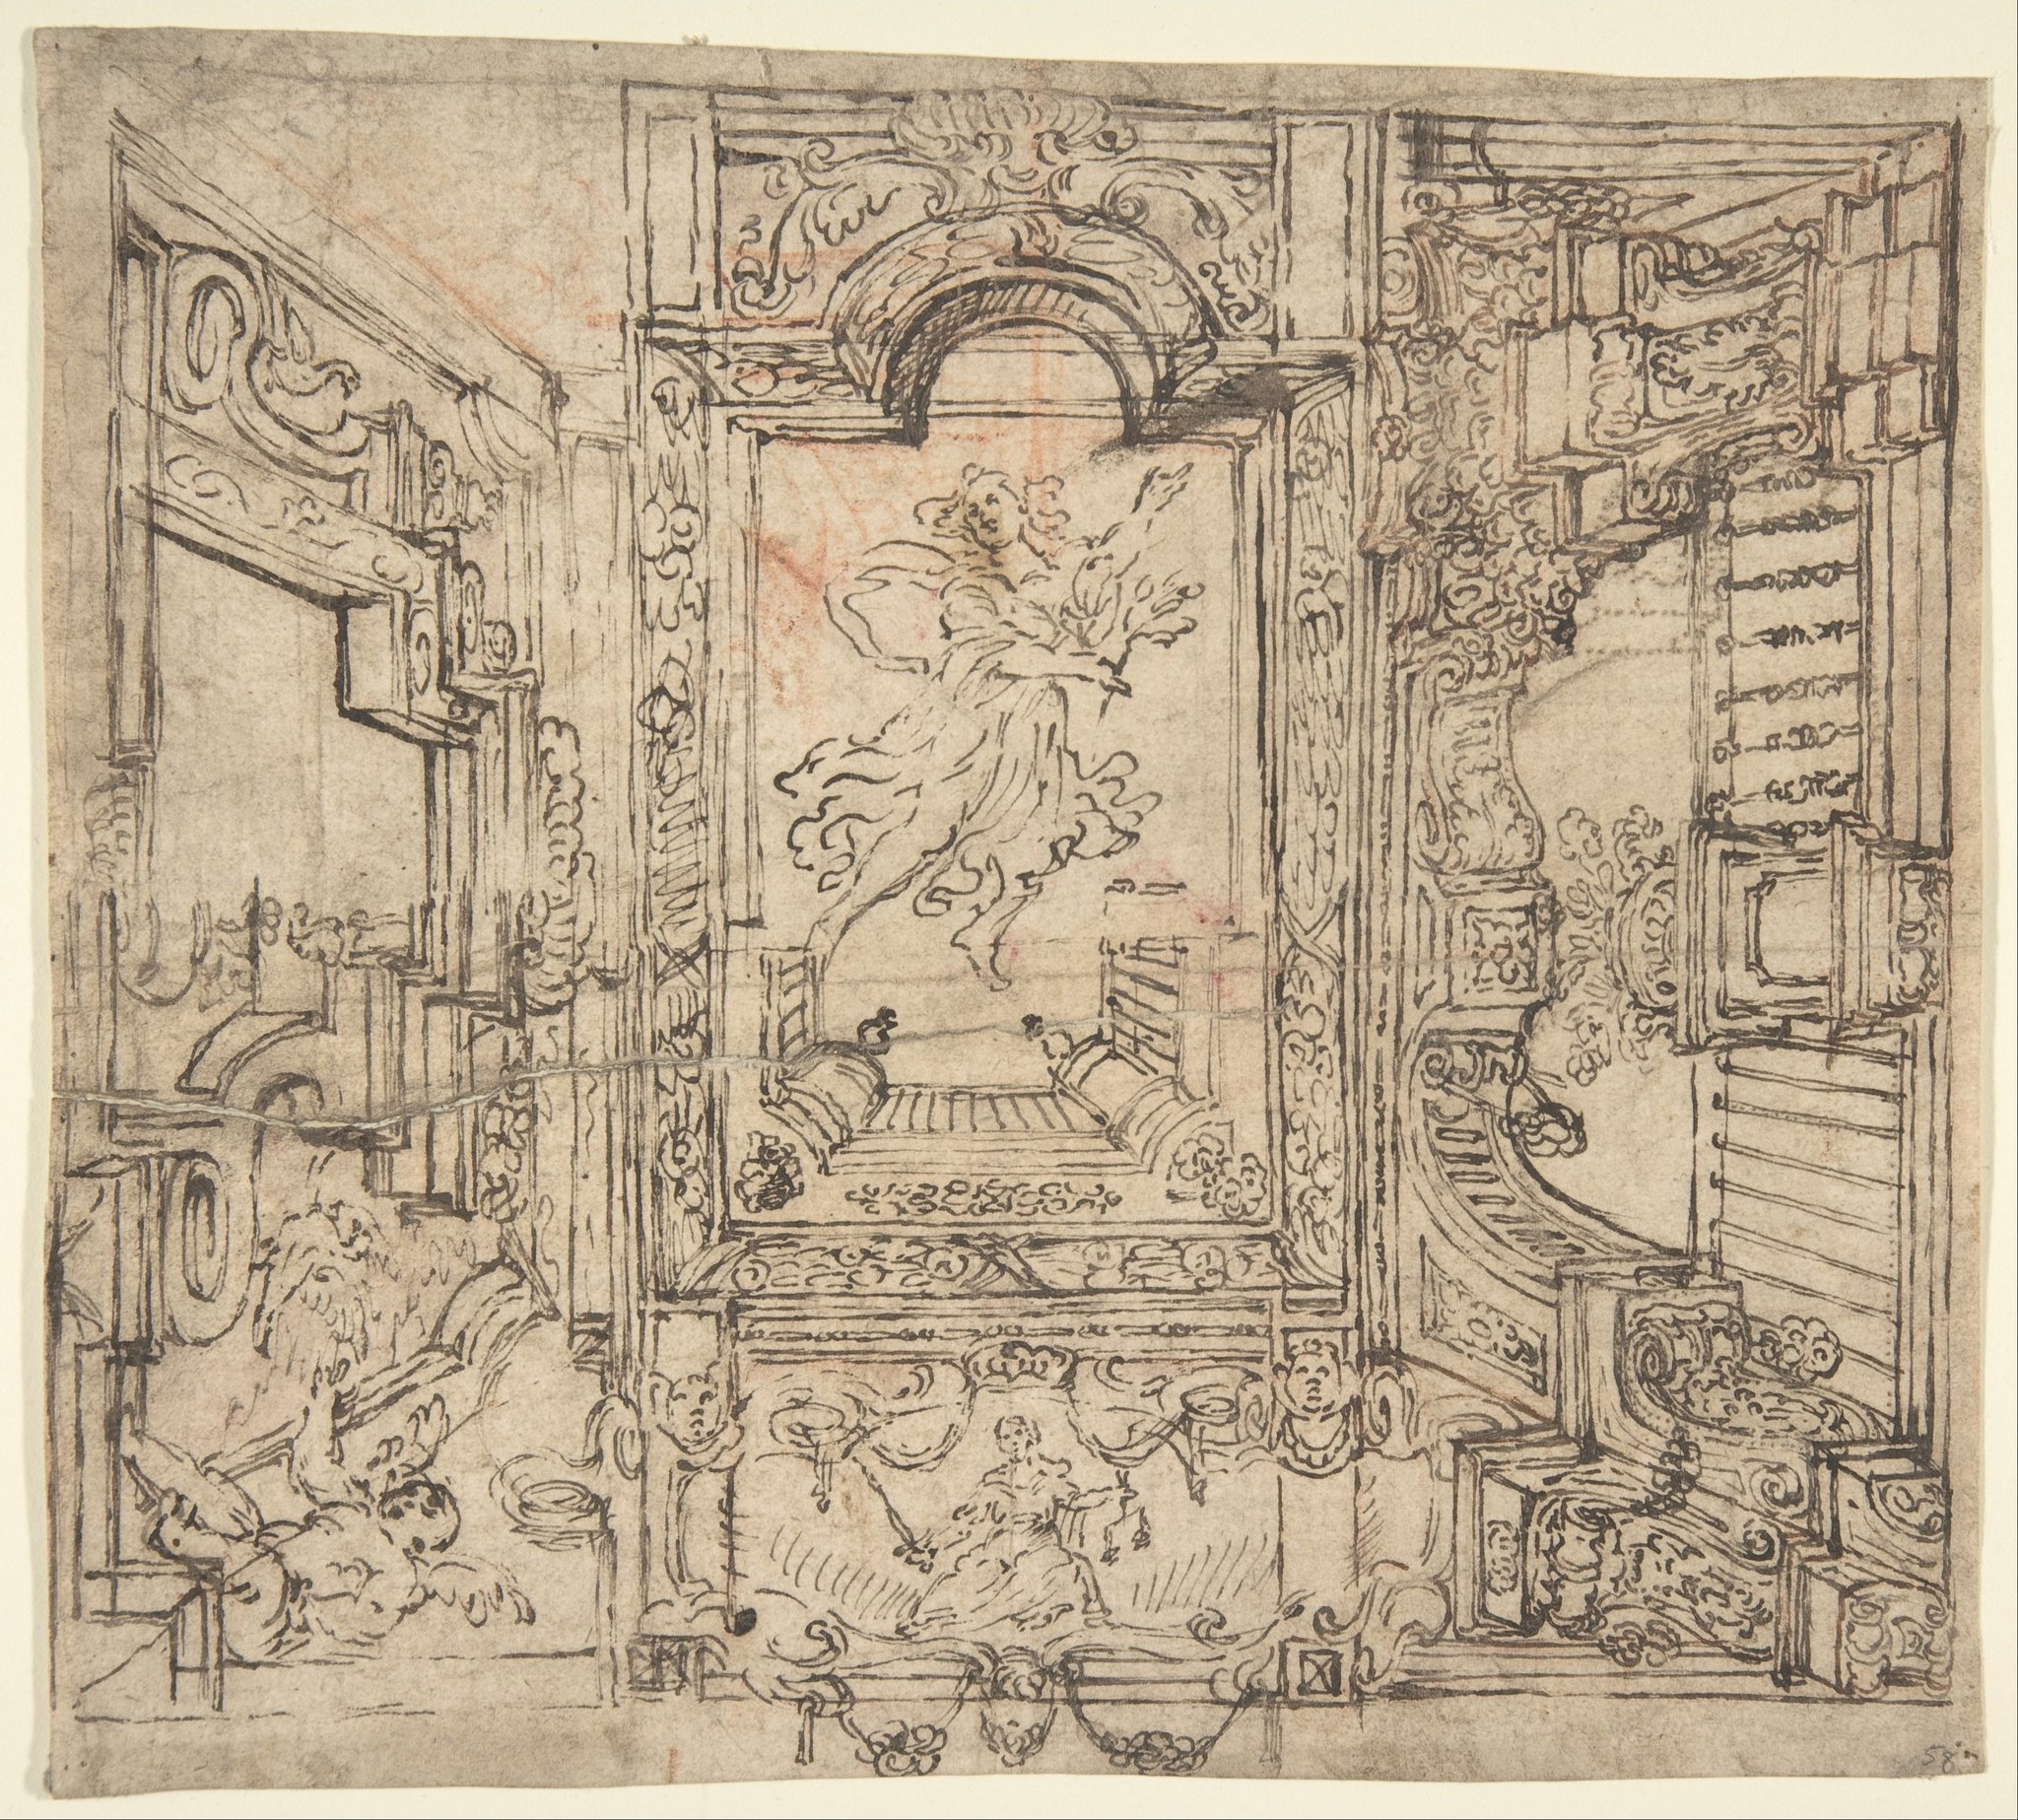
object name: drawing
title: Design for a Painted Ceiling: Perspective Architectural with a Figure at the Center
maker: anonymous, italian, piedmontese, 18th century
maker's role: artist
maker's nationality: italian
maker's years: 1700-1800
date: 1700-1780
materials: chalk, ink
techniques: pen, transfer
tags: human figures,architecture